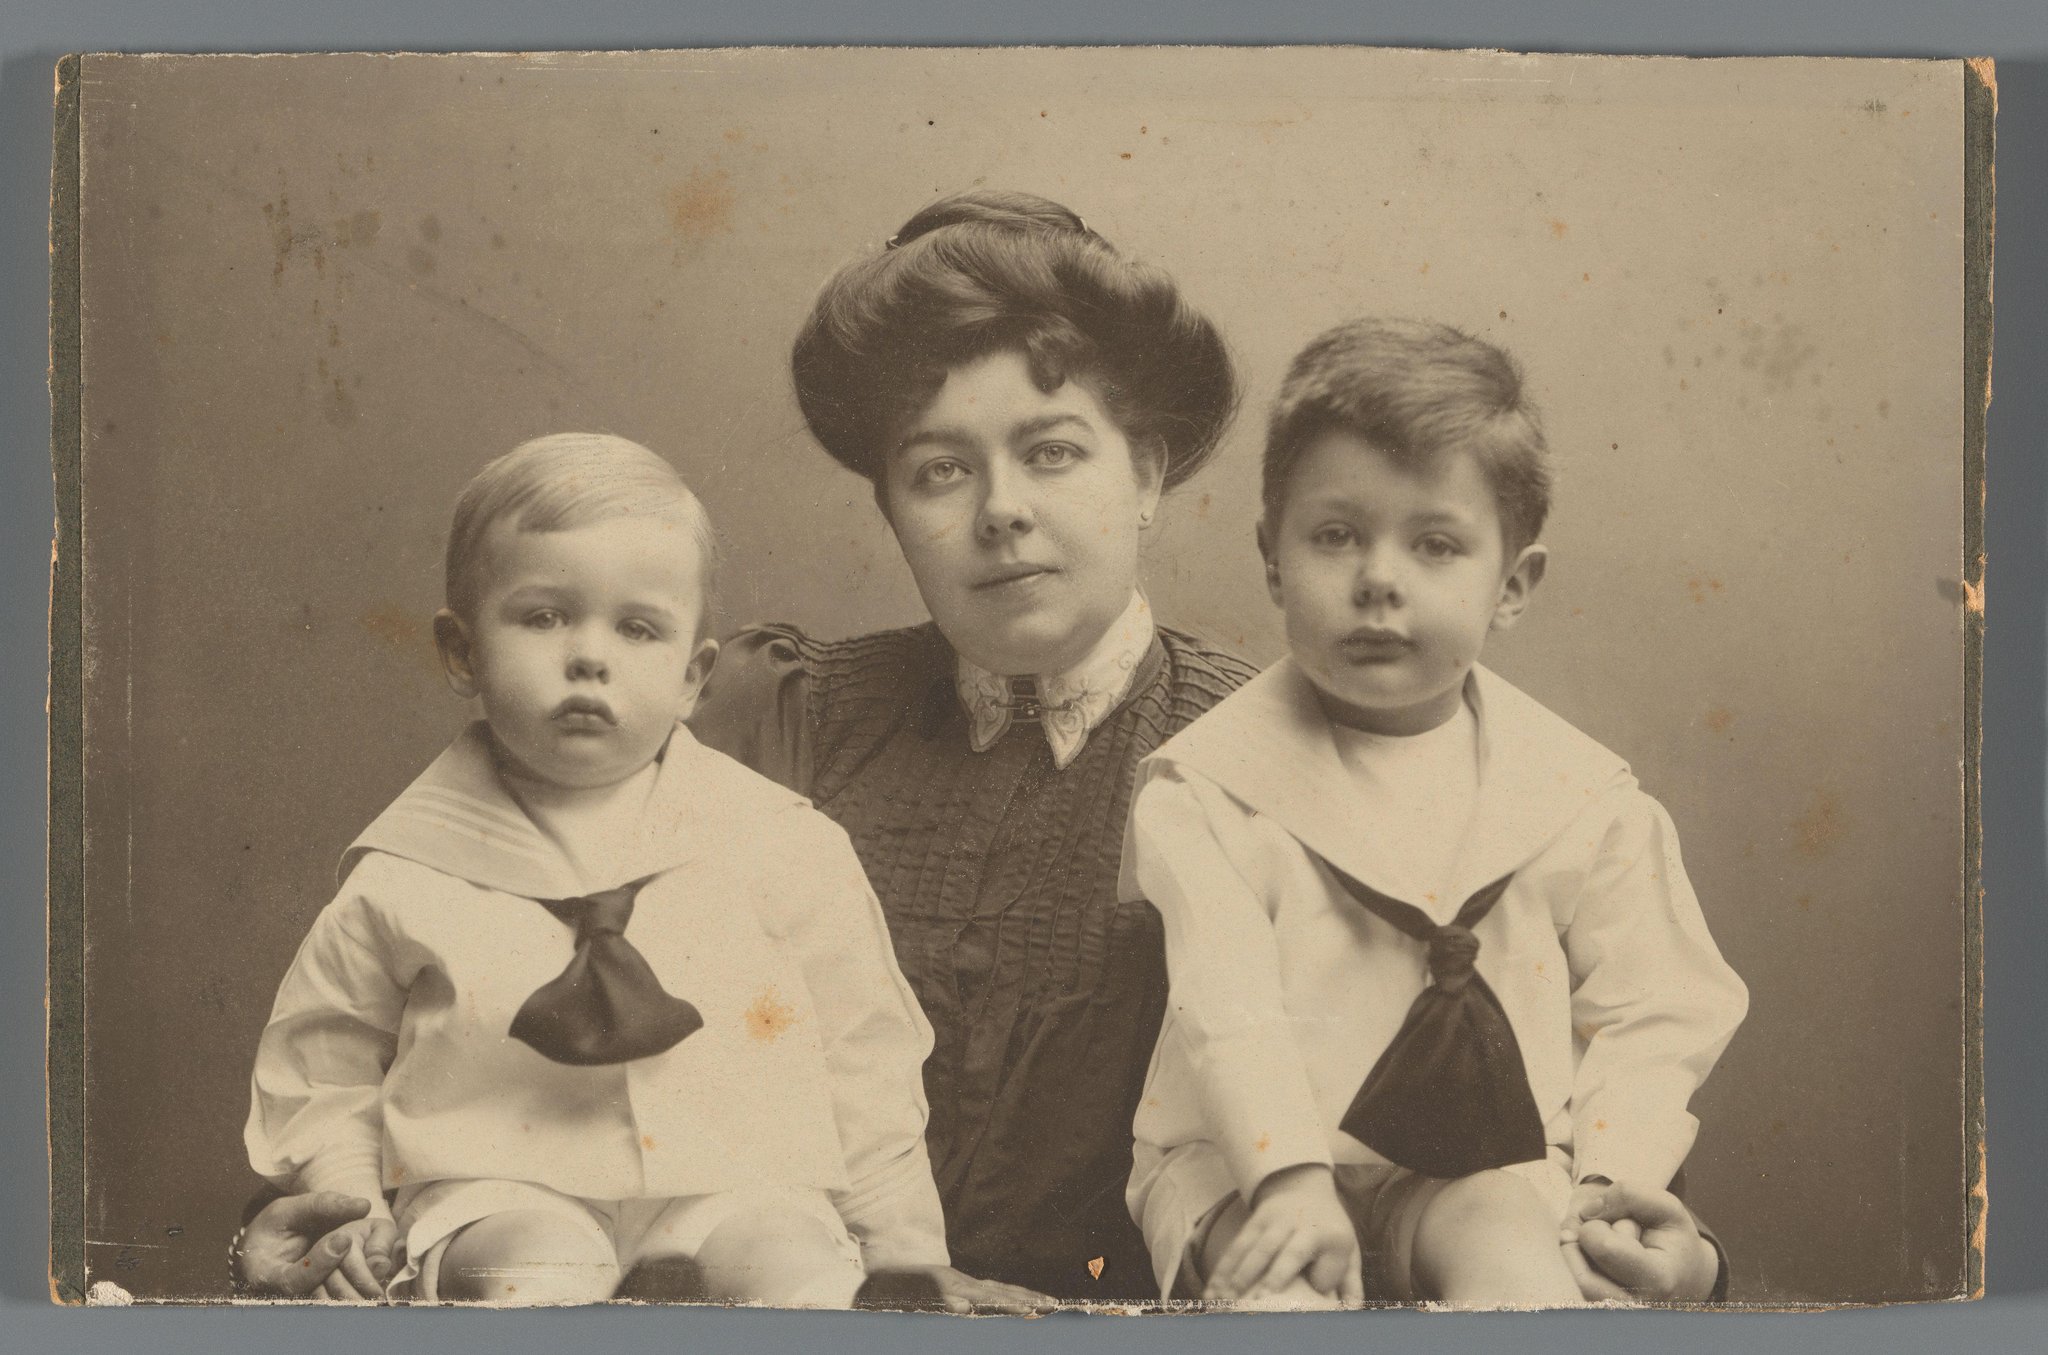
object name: photograph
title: A.C.M. Geertsema tussen haar twee jonge kinderen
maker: Anonymous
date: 1900-1920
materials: cardboard, photographic support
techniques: albumen print